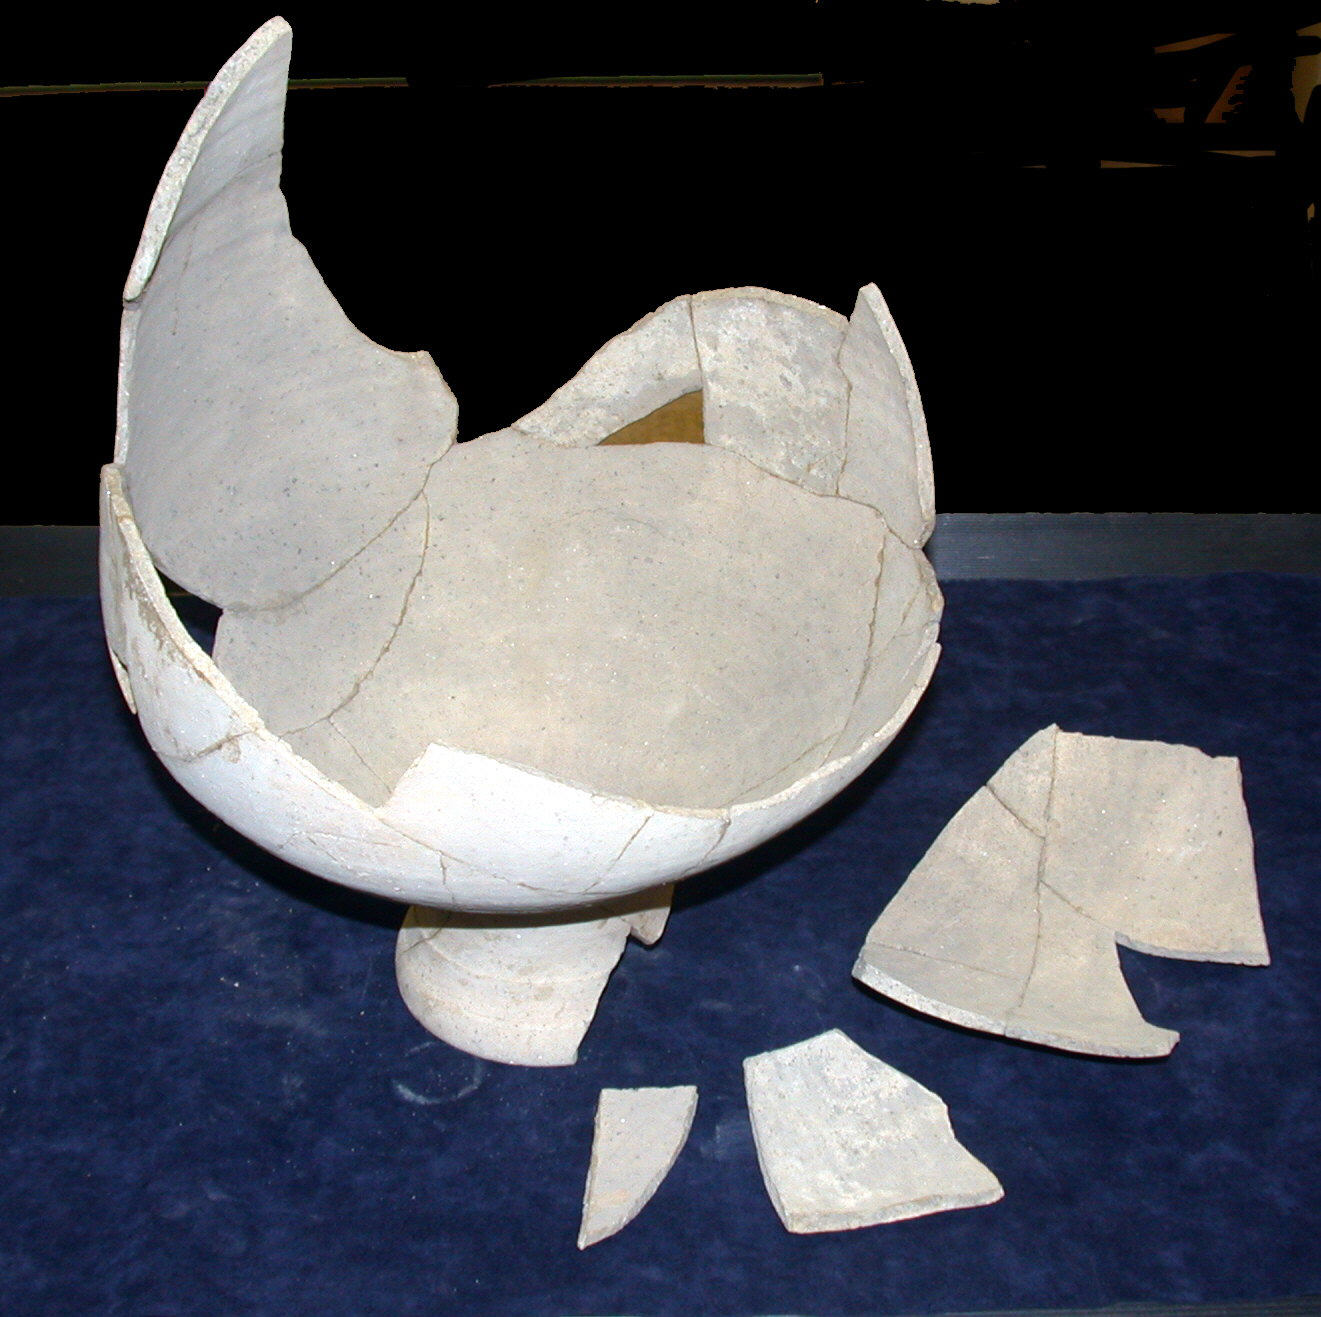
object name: jug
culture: sasanian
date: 201-700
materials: ceramic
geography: iran